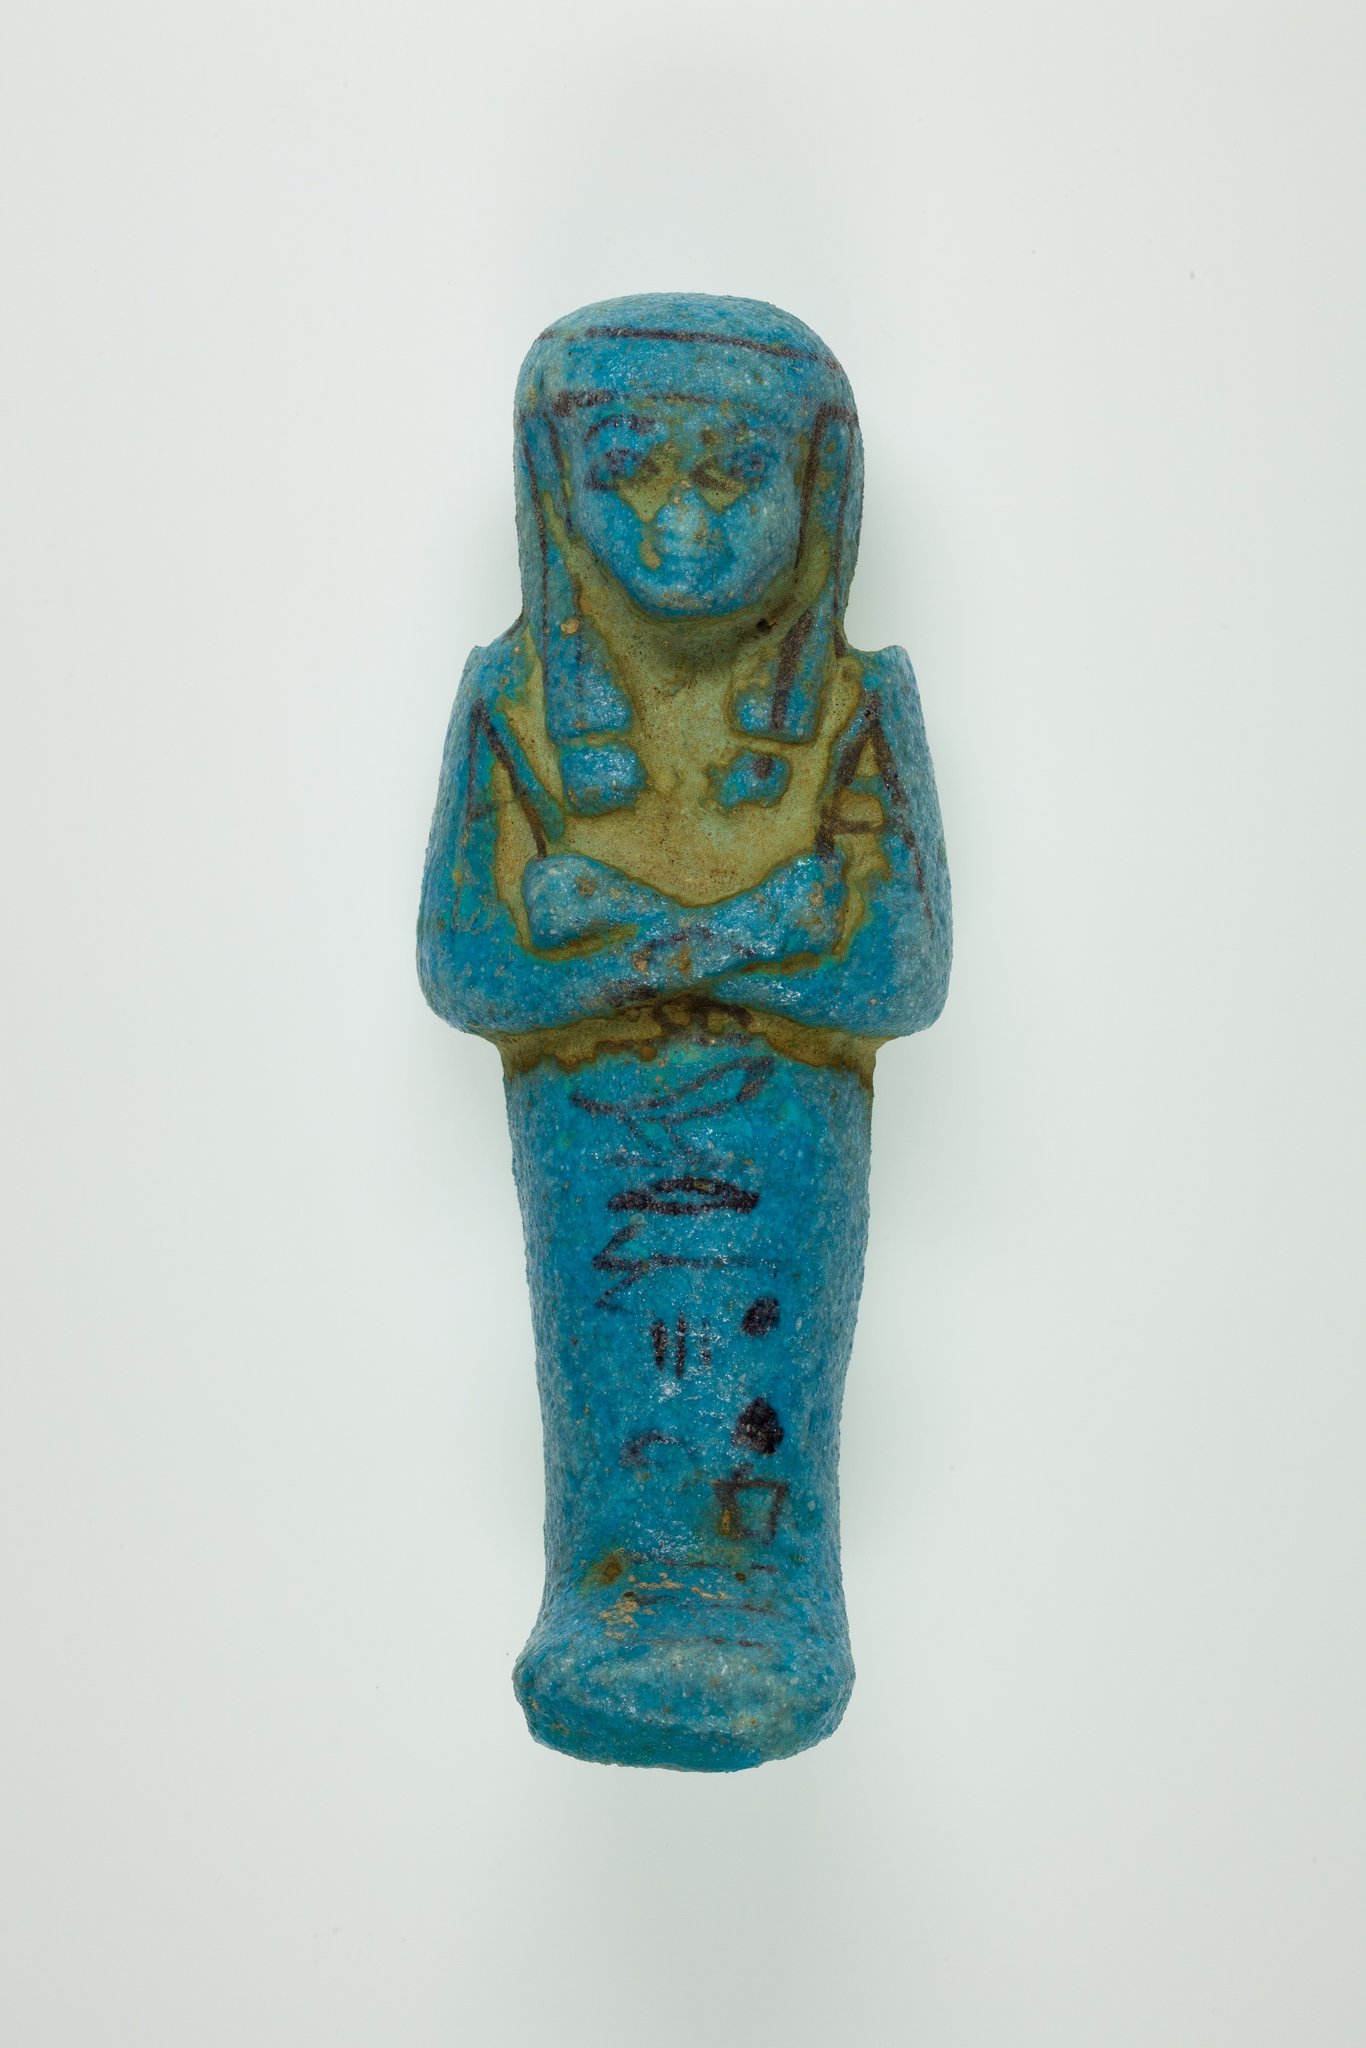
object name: worker shabti, henettawy c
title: Worker Shabti of Henettawy (C), Daughter of Isetemkheb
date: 990-970 BCE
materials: faience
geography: egypt